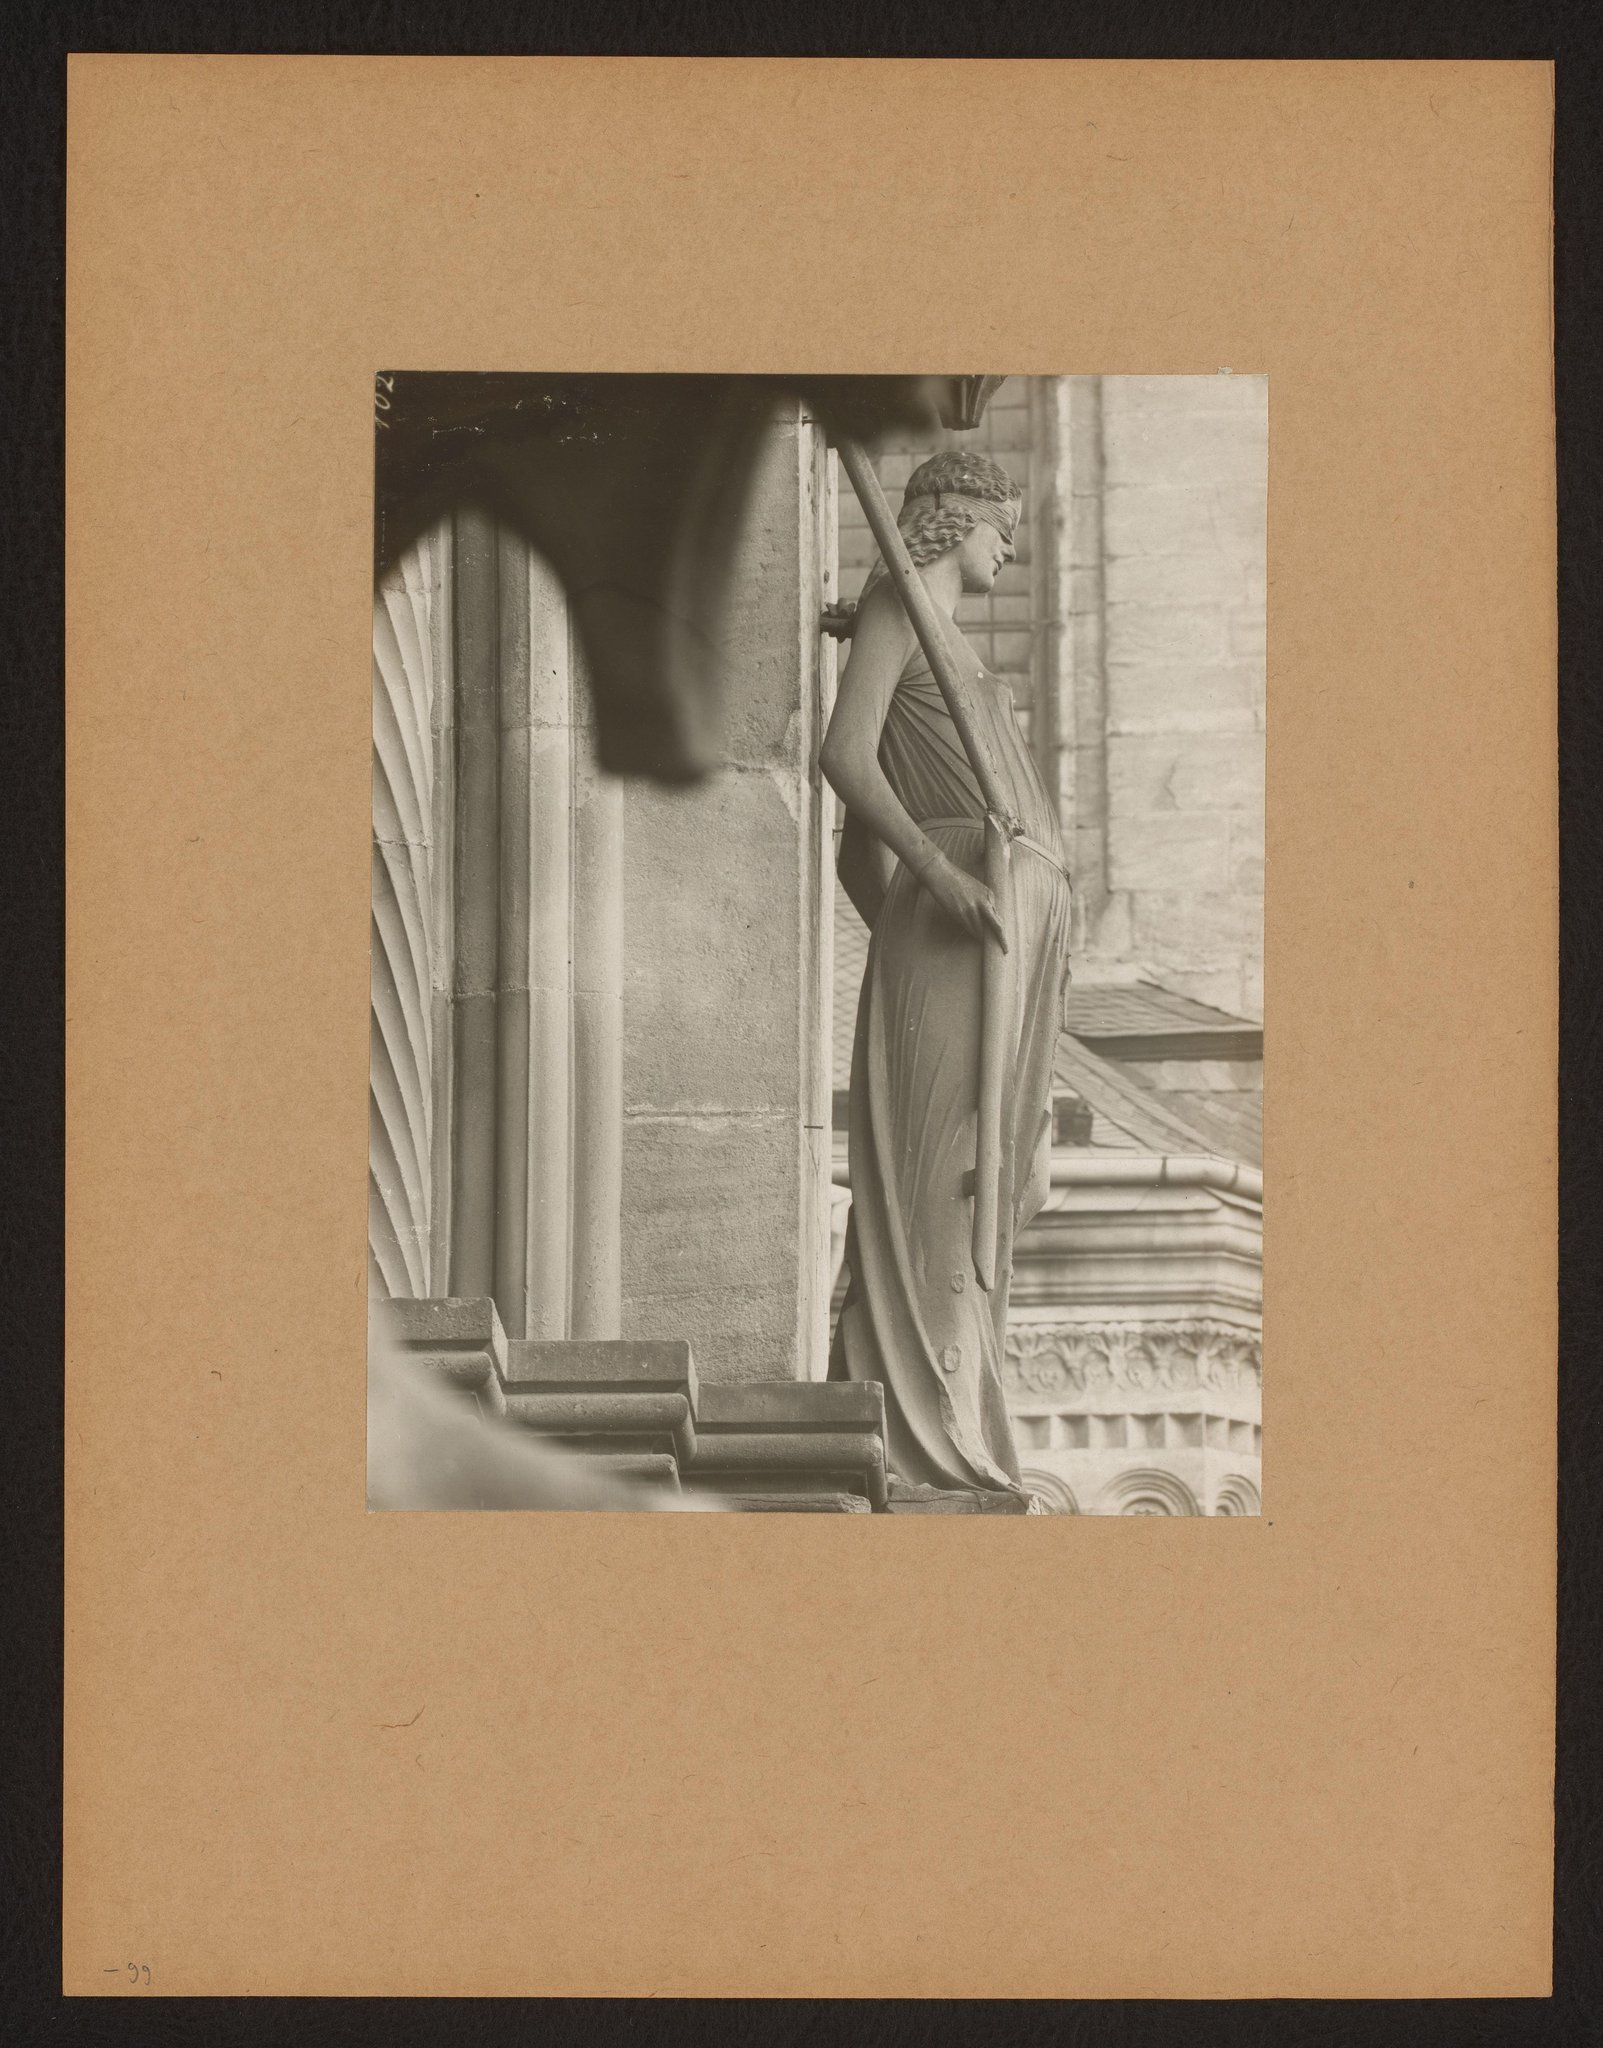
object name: album leaf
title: Detail van het Fürstenportal in de dom van Bamberg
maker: Anonymous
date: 1900-1920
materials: paper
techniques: gelatin silver print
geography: bamberg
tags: church (exterior)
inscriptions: number: ‘102’